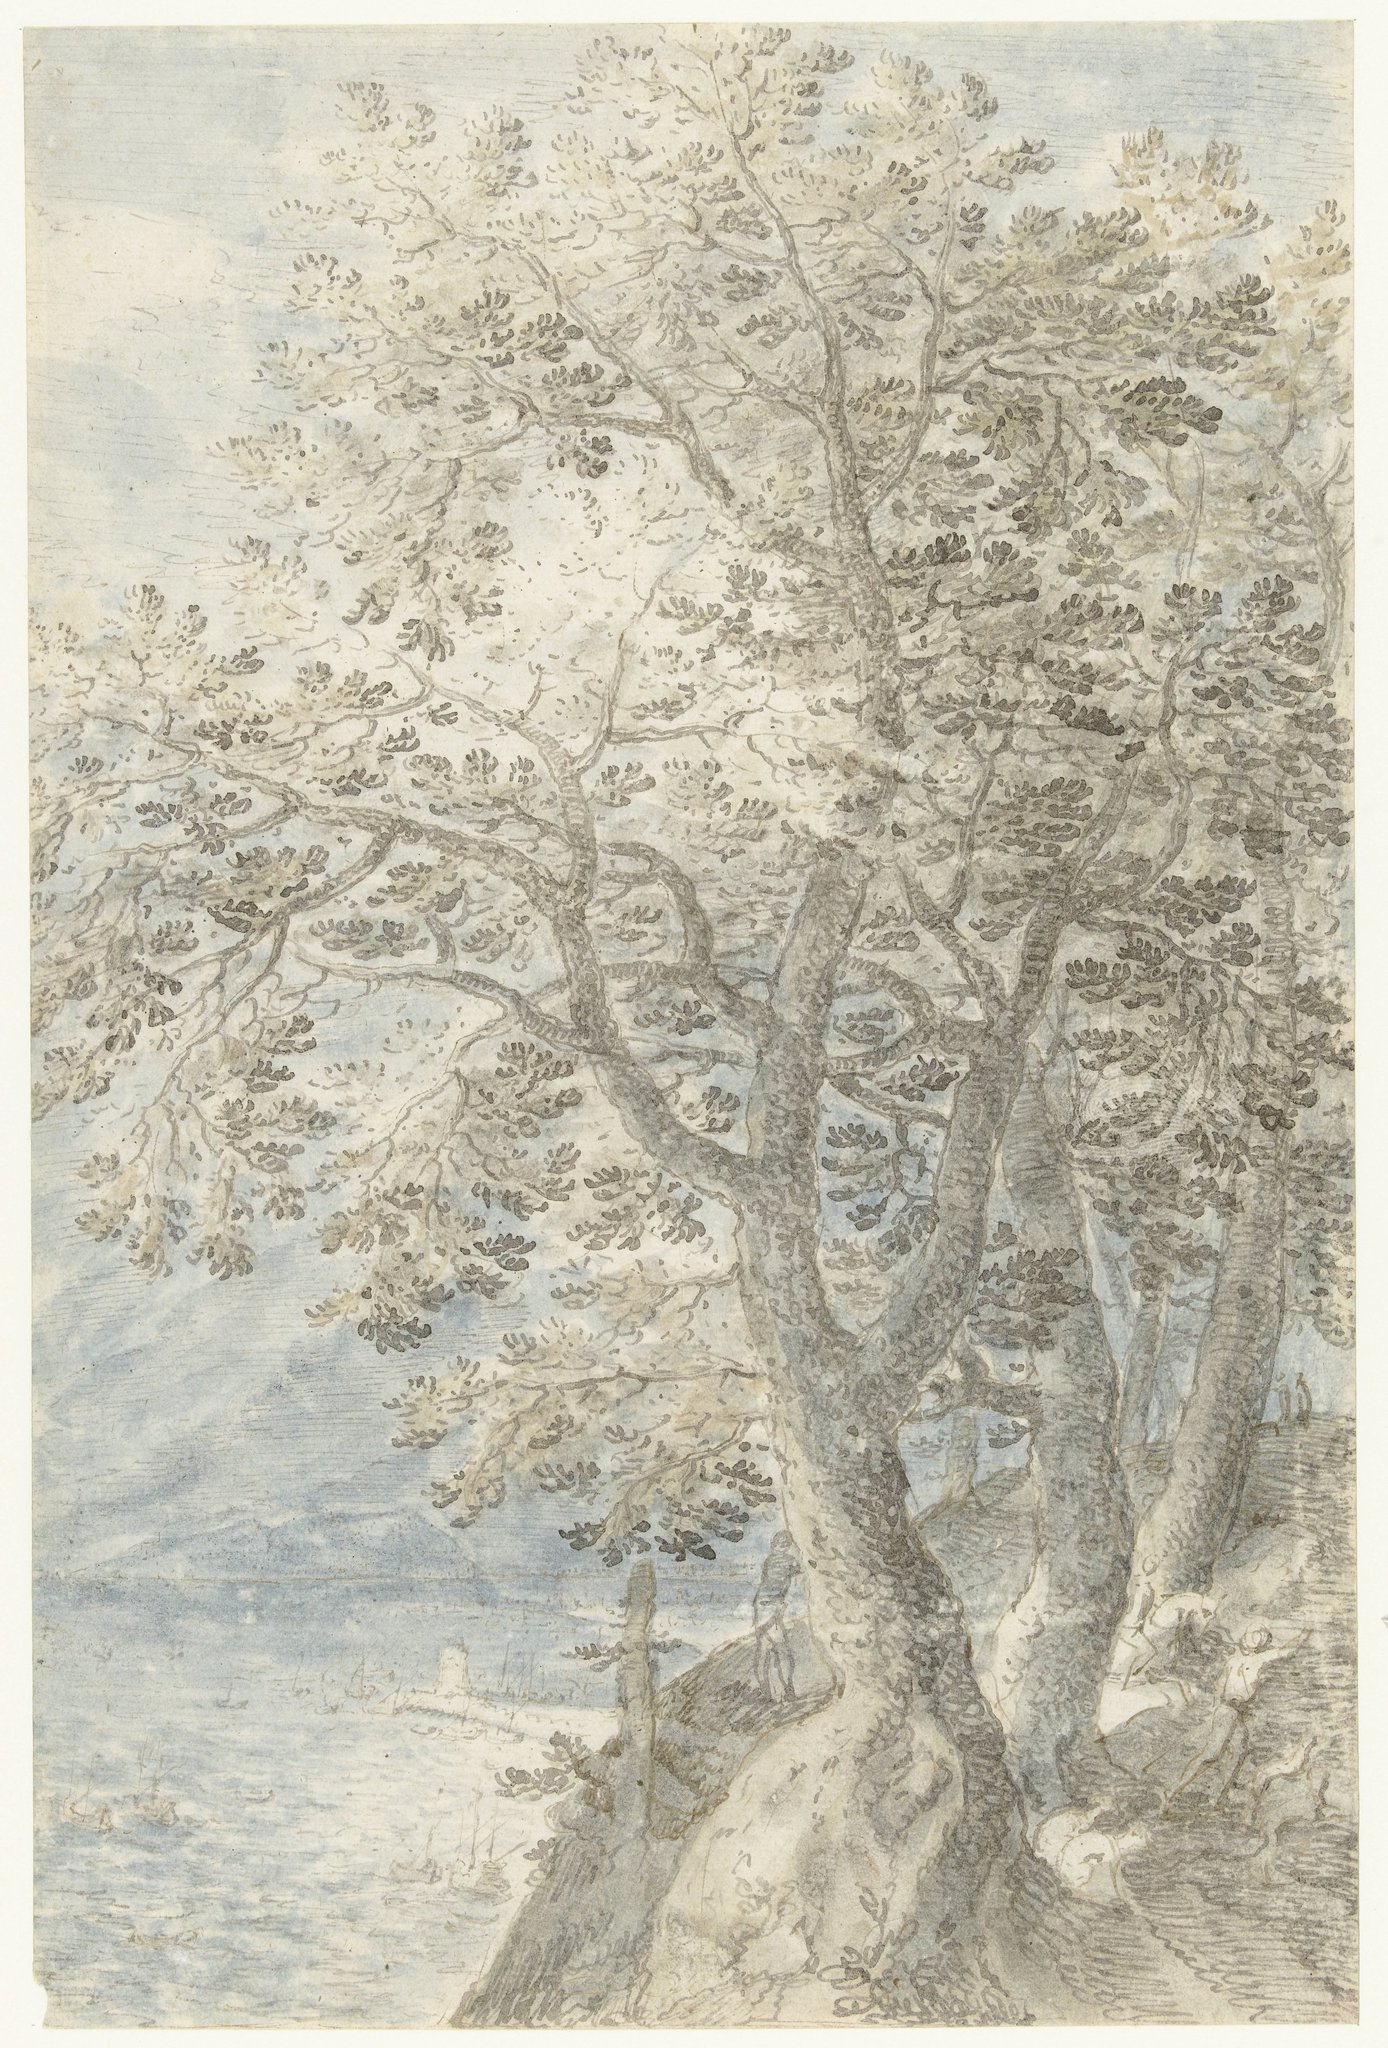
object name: drawing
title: Bomen bij steile rotswand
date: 1597-1599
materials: paper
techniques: brush, pen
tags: trees, groups of trees